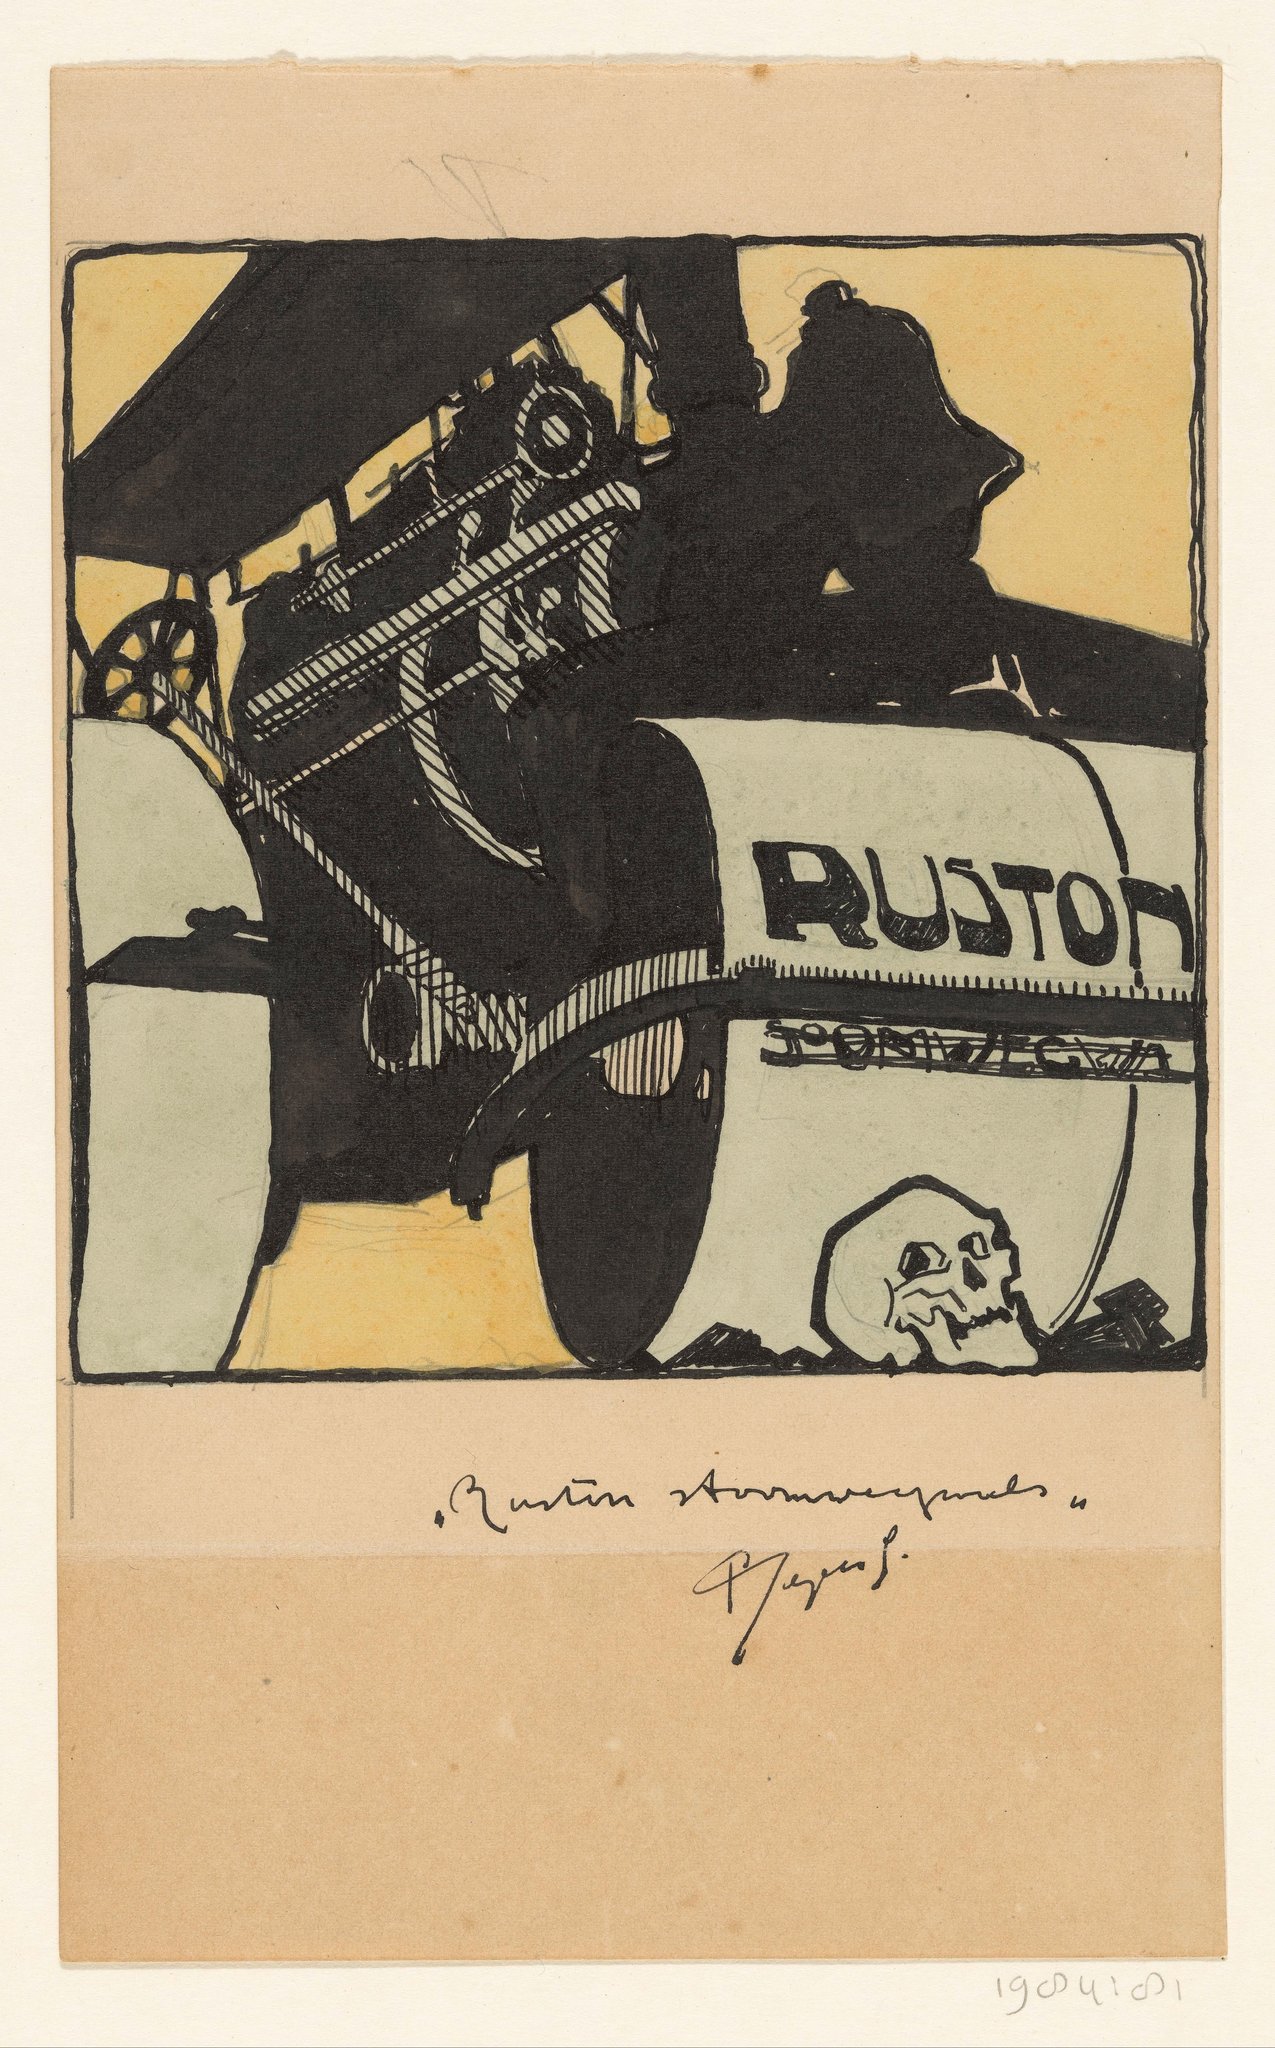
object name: drawing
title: Ruston stoomwegwals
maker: reijer stolk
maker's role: draughtsman, print maker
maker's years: 1896-1945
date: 1918-1945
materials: ink, paper, pencil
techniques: brush, pen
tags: (other) historical names, advertisement, notice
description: In 1918 fuseerden twee leveranciers voor industrieel materieel tot Ruston & Hornsby en produceerden onder meer stoomlocomotieven, auto's, stoomwalsen en verbrandingsmotoren.